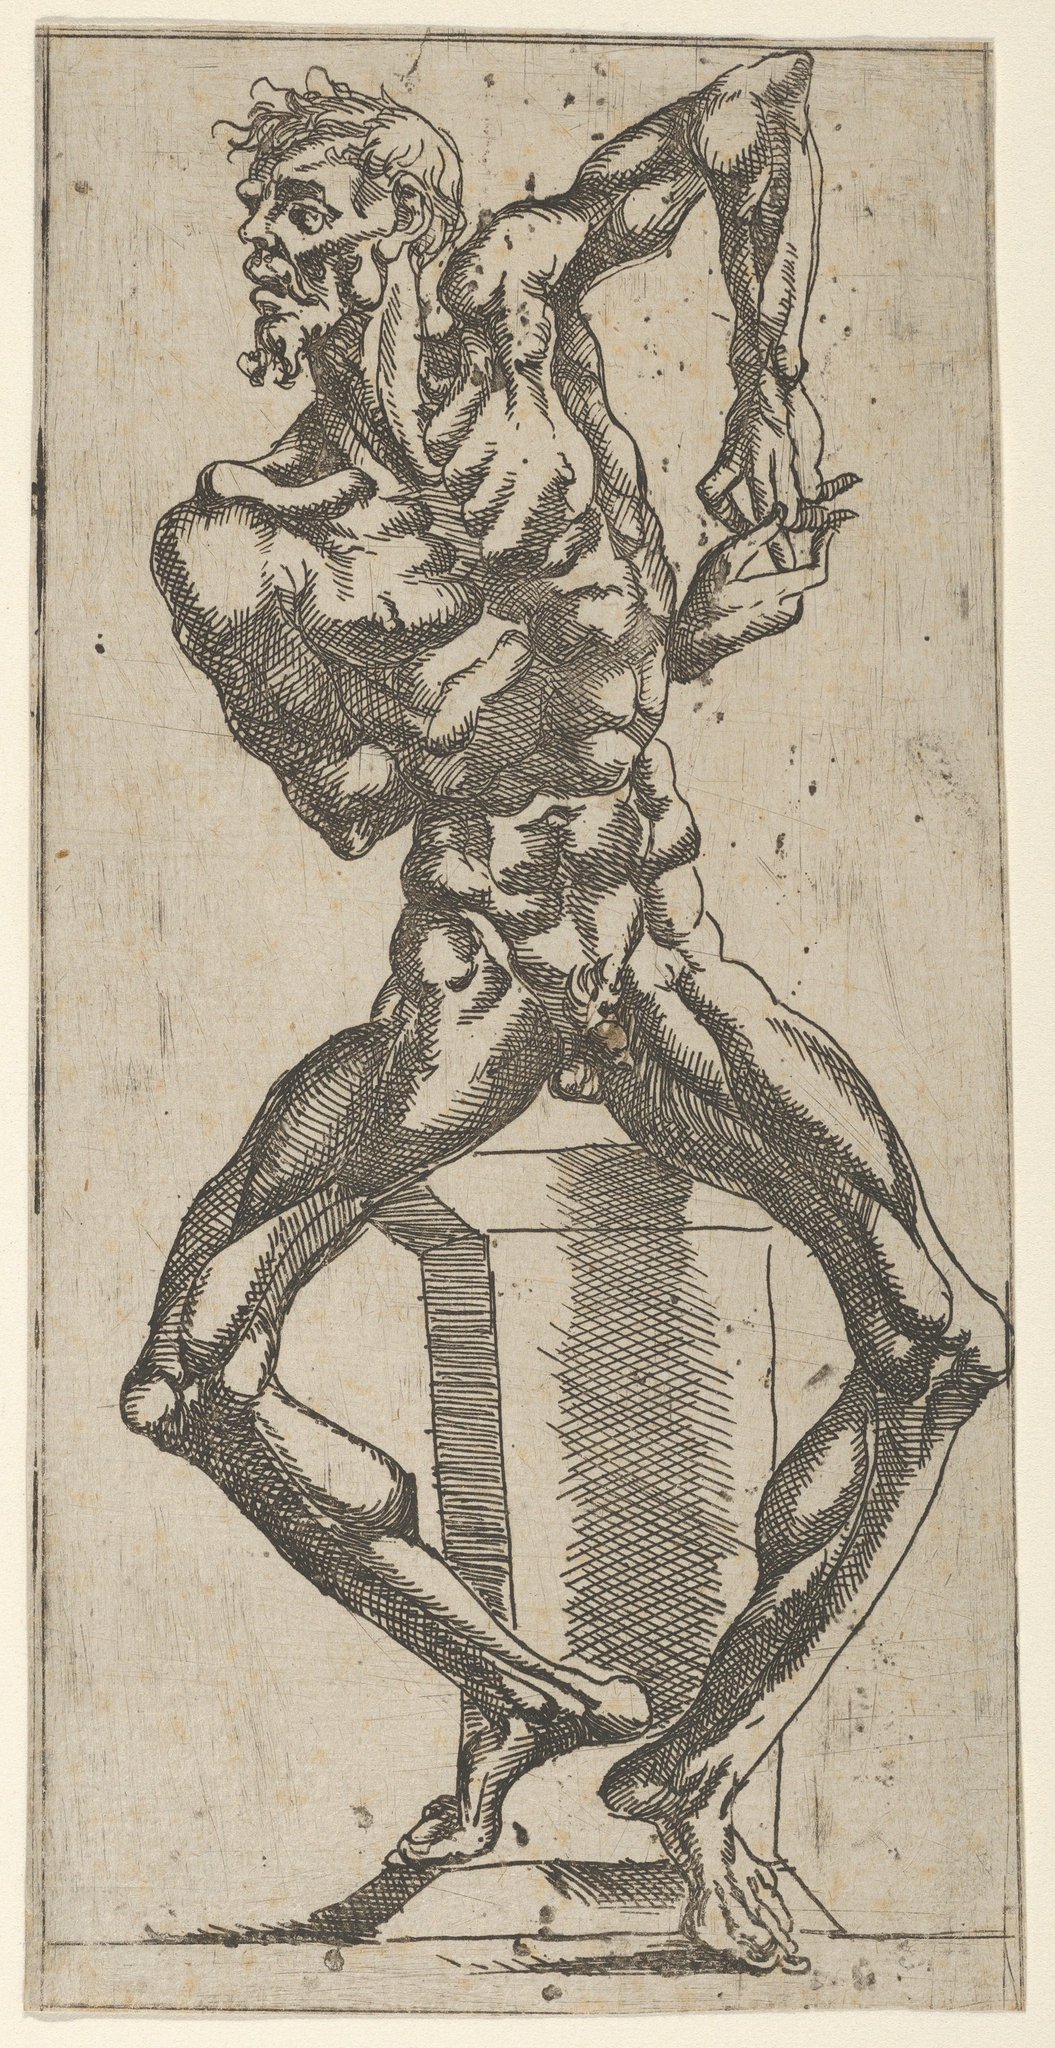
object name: print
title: Naked Figure leaning on a Pedestal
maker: juste de juste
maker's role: artist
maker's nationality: french, born italy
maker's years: 1505-1559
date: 1540-1550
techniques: etching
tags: male nudes